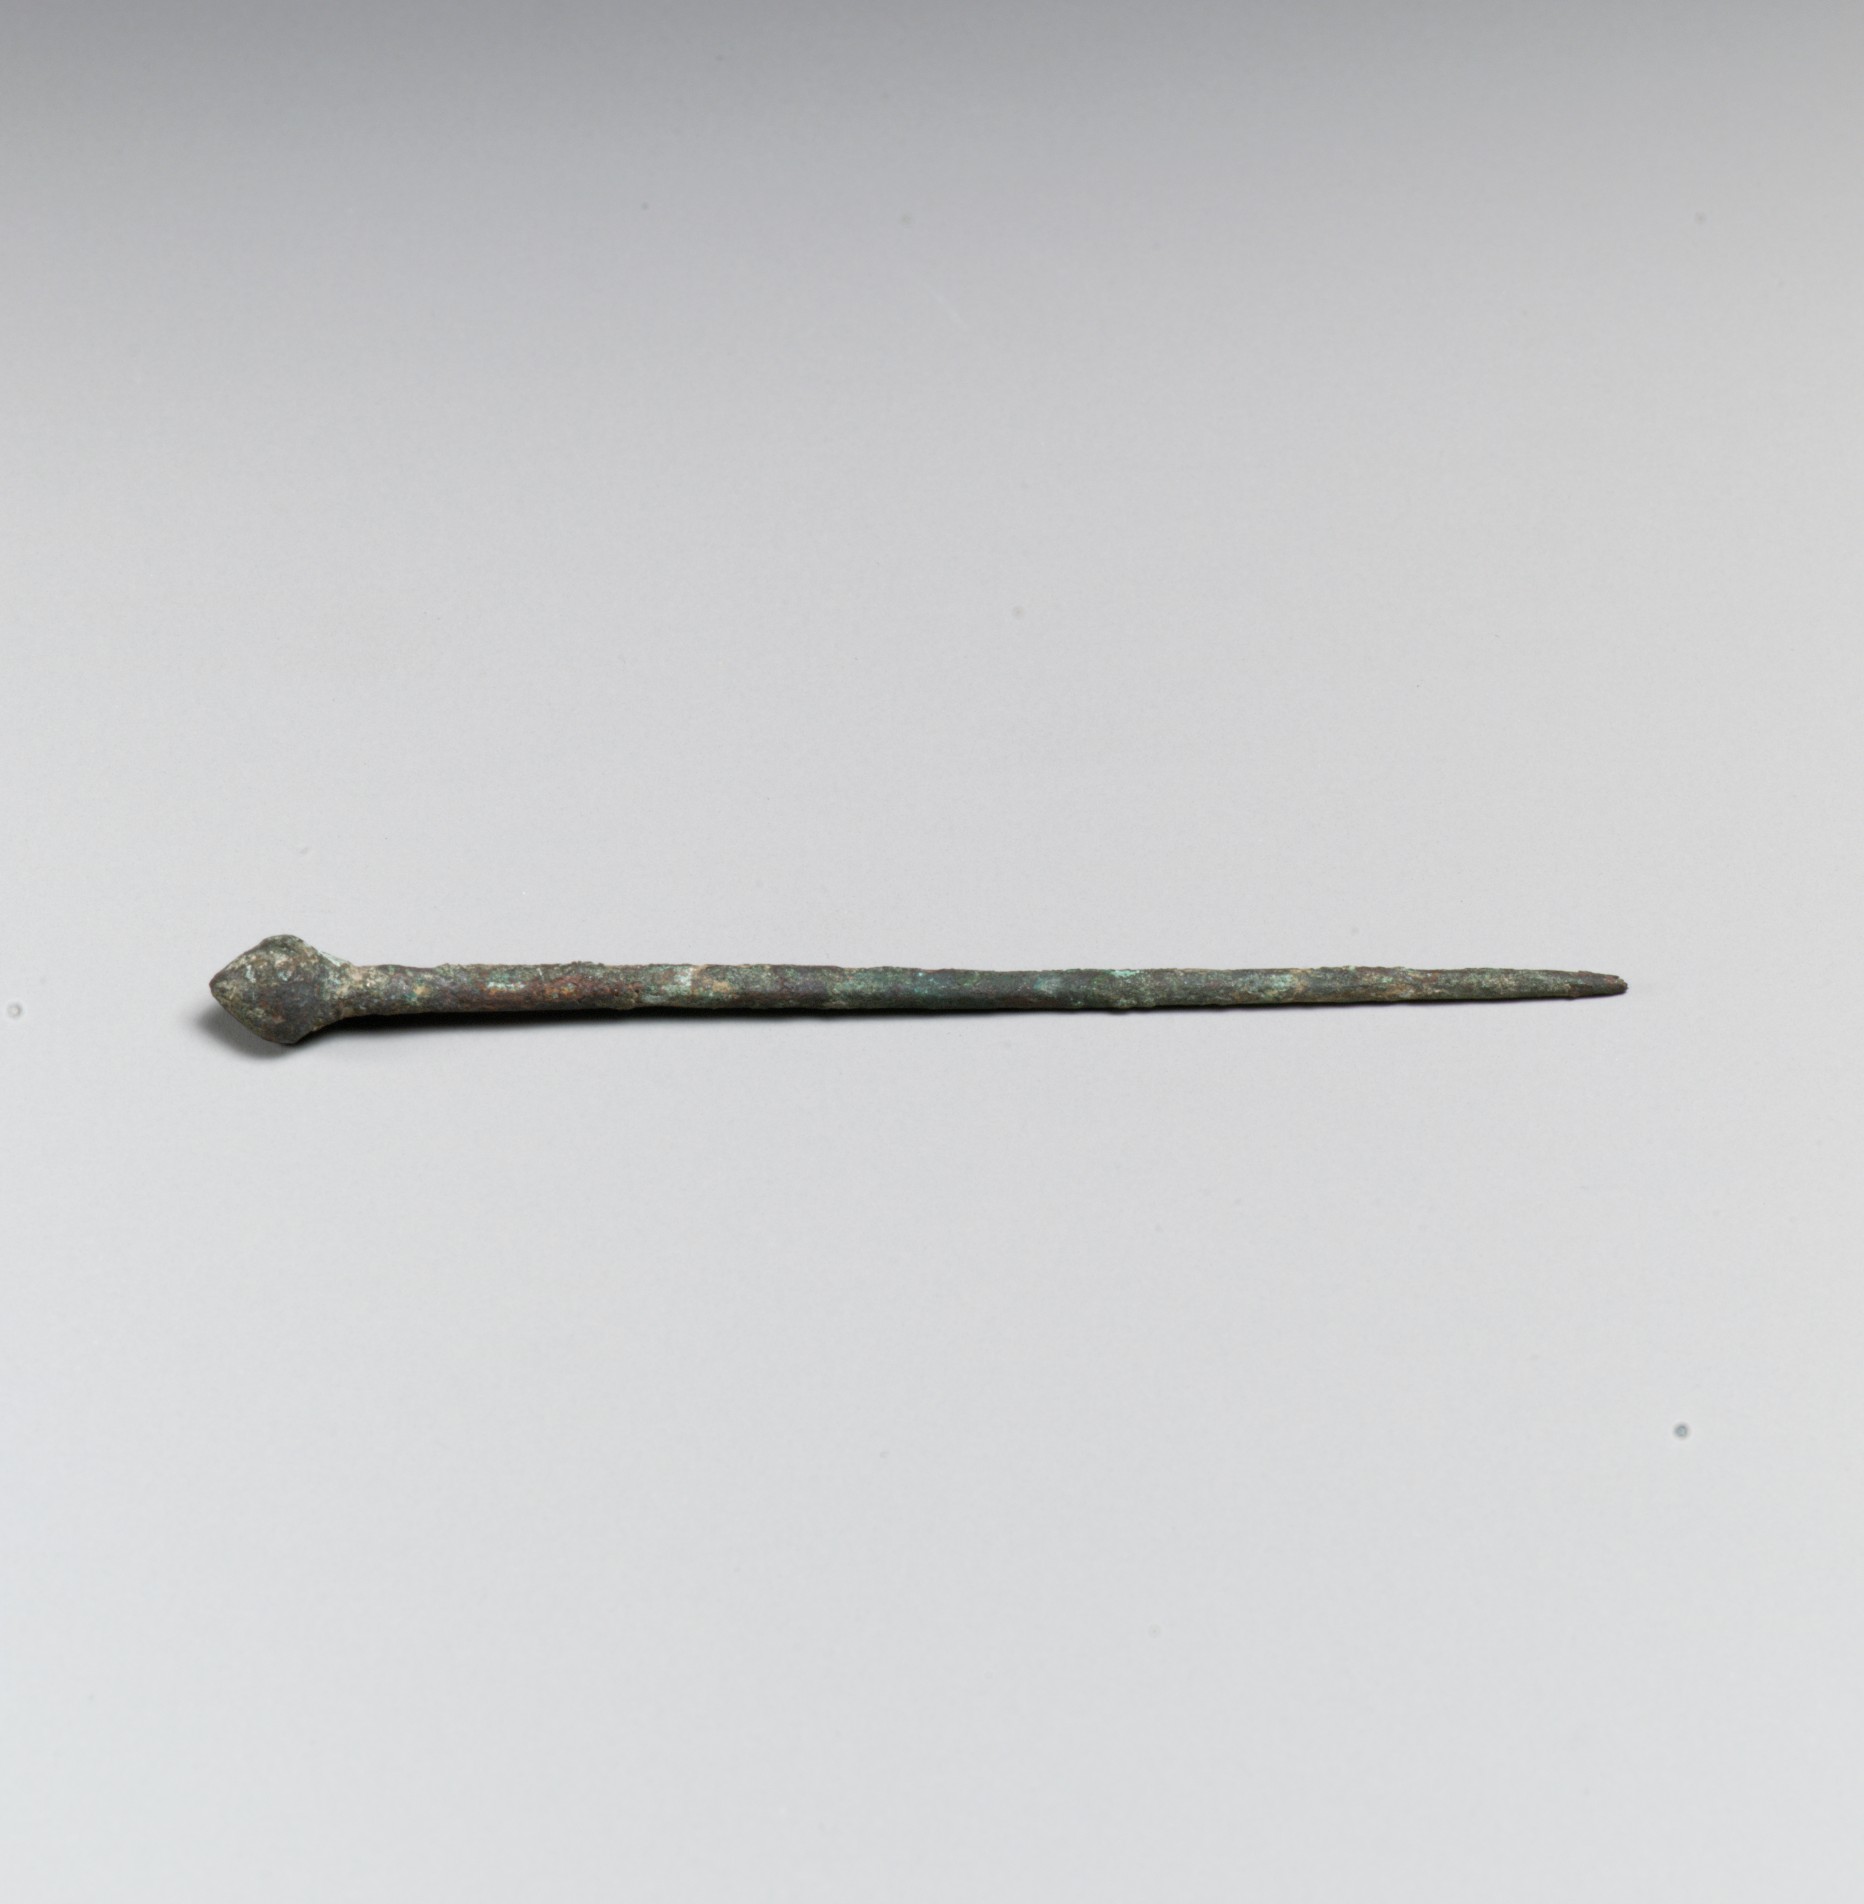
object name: pin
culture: roman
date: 670 BCE-330 CE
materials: bronze